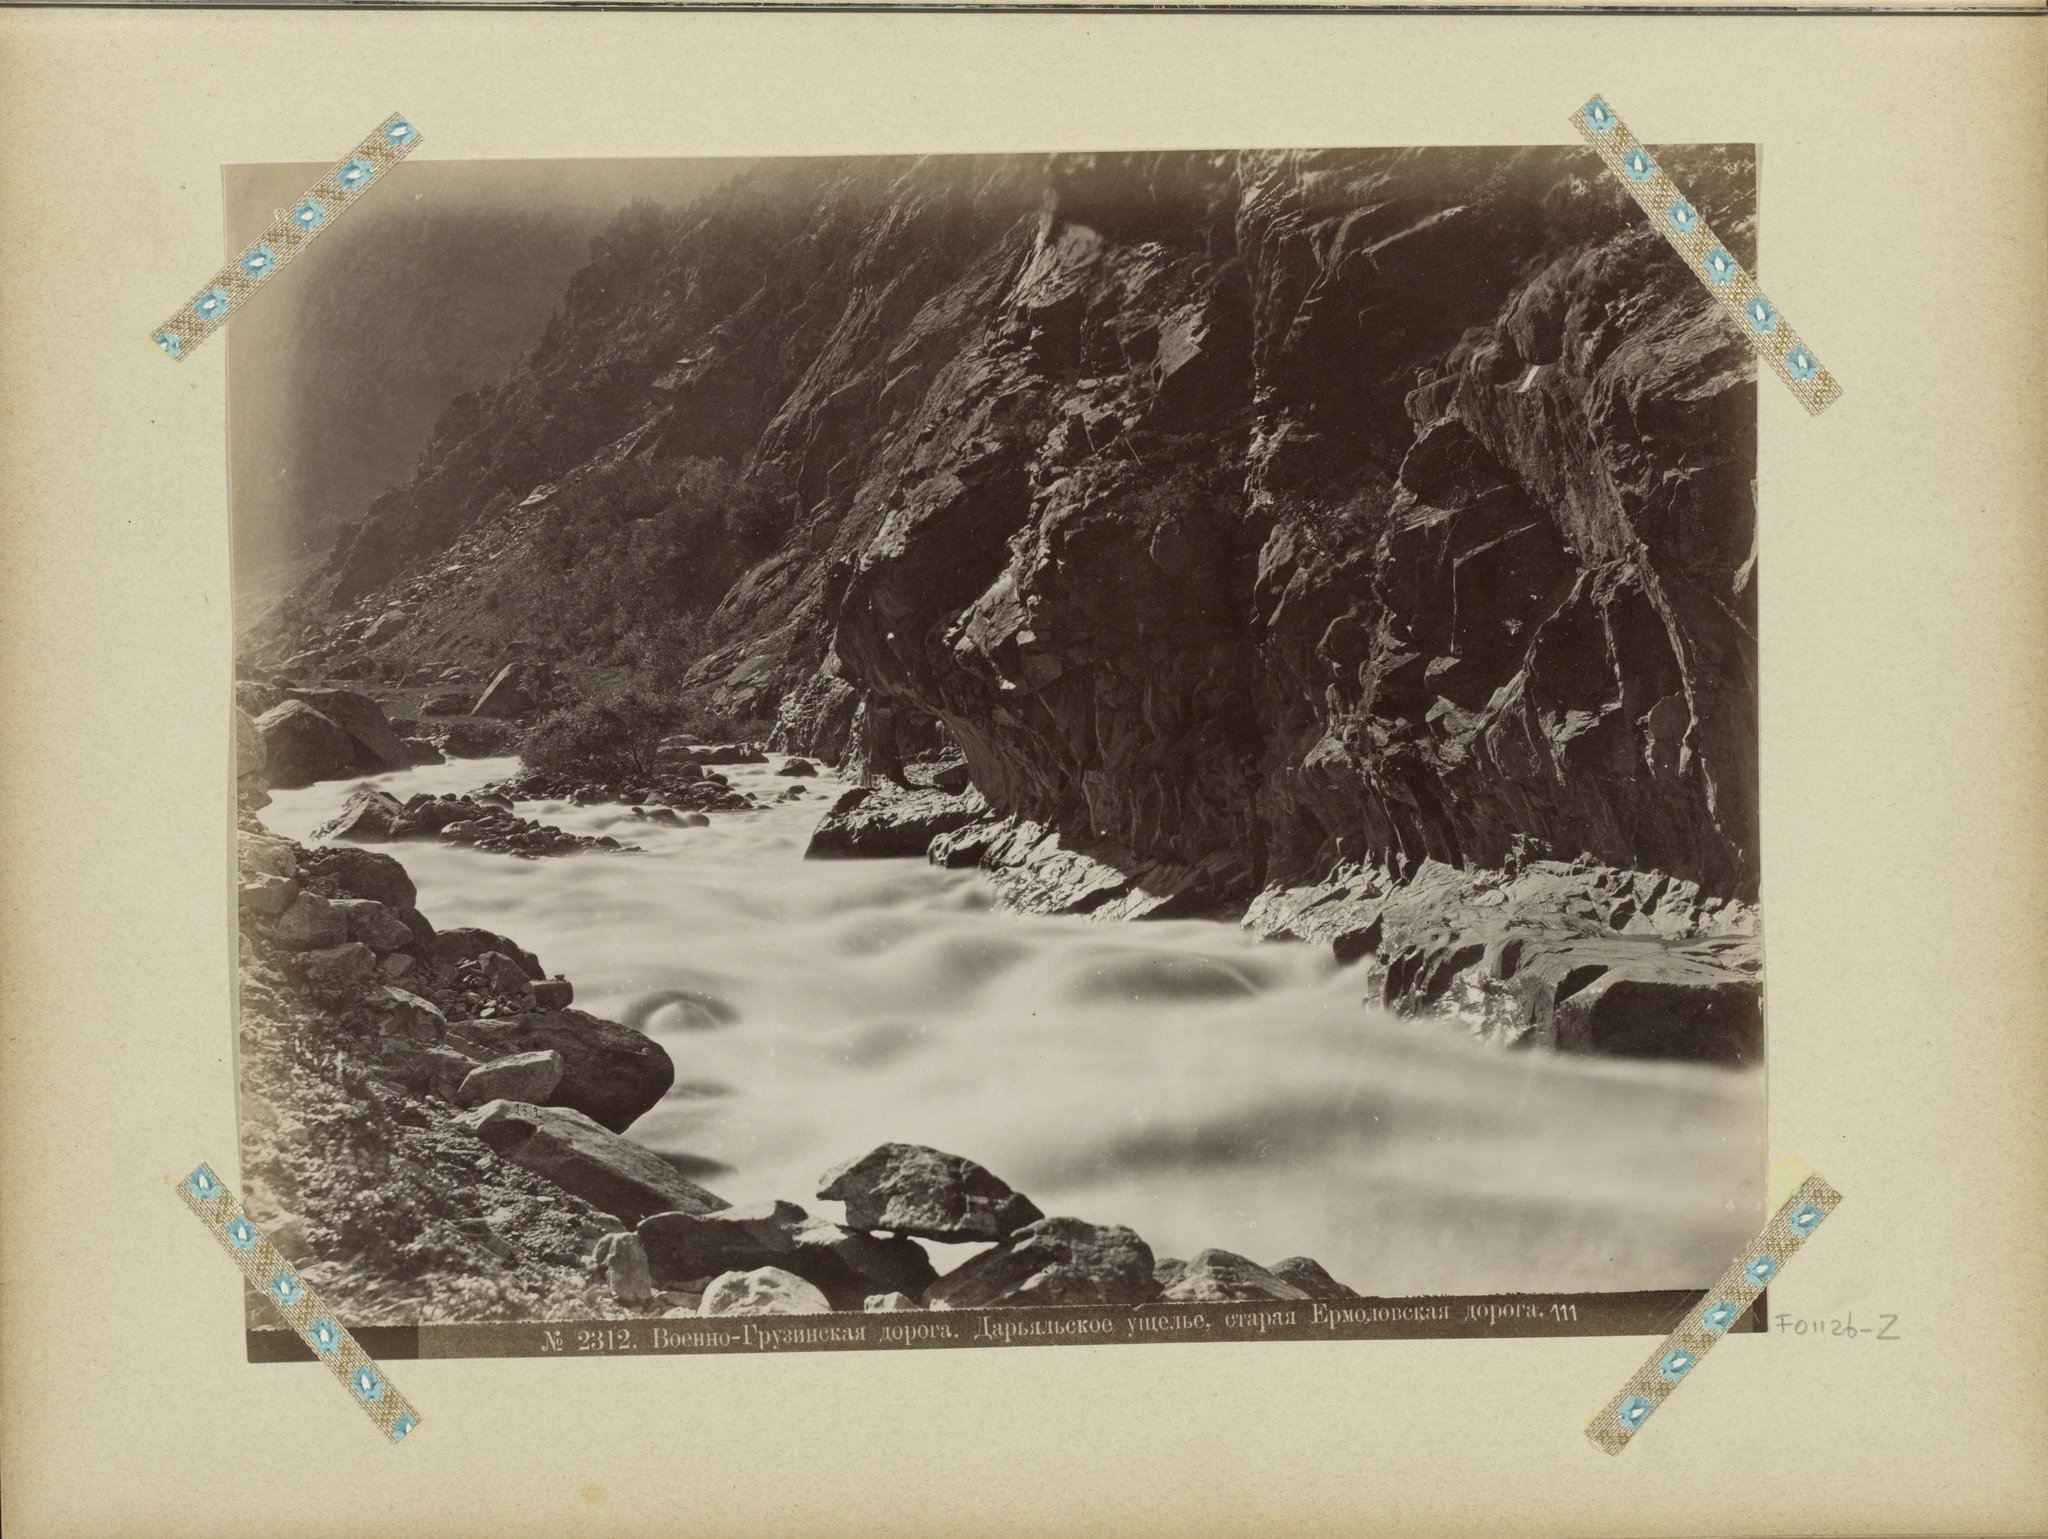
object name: photograph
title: Berglandschap met rivier in Georgië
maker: dimitri ivanovitch ermakov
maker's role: fotograaf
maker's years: 1845-1916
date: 1890-1900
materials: photographic support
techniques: albumen print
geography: georgia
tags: river, rock-formations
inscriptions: number: ‘111’, number: ‘2312’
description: Onderdeel van Fotoalbum met opnames van bezienswaardigheden in Georgië, Sint-Petersburg en Moskou.